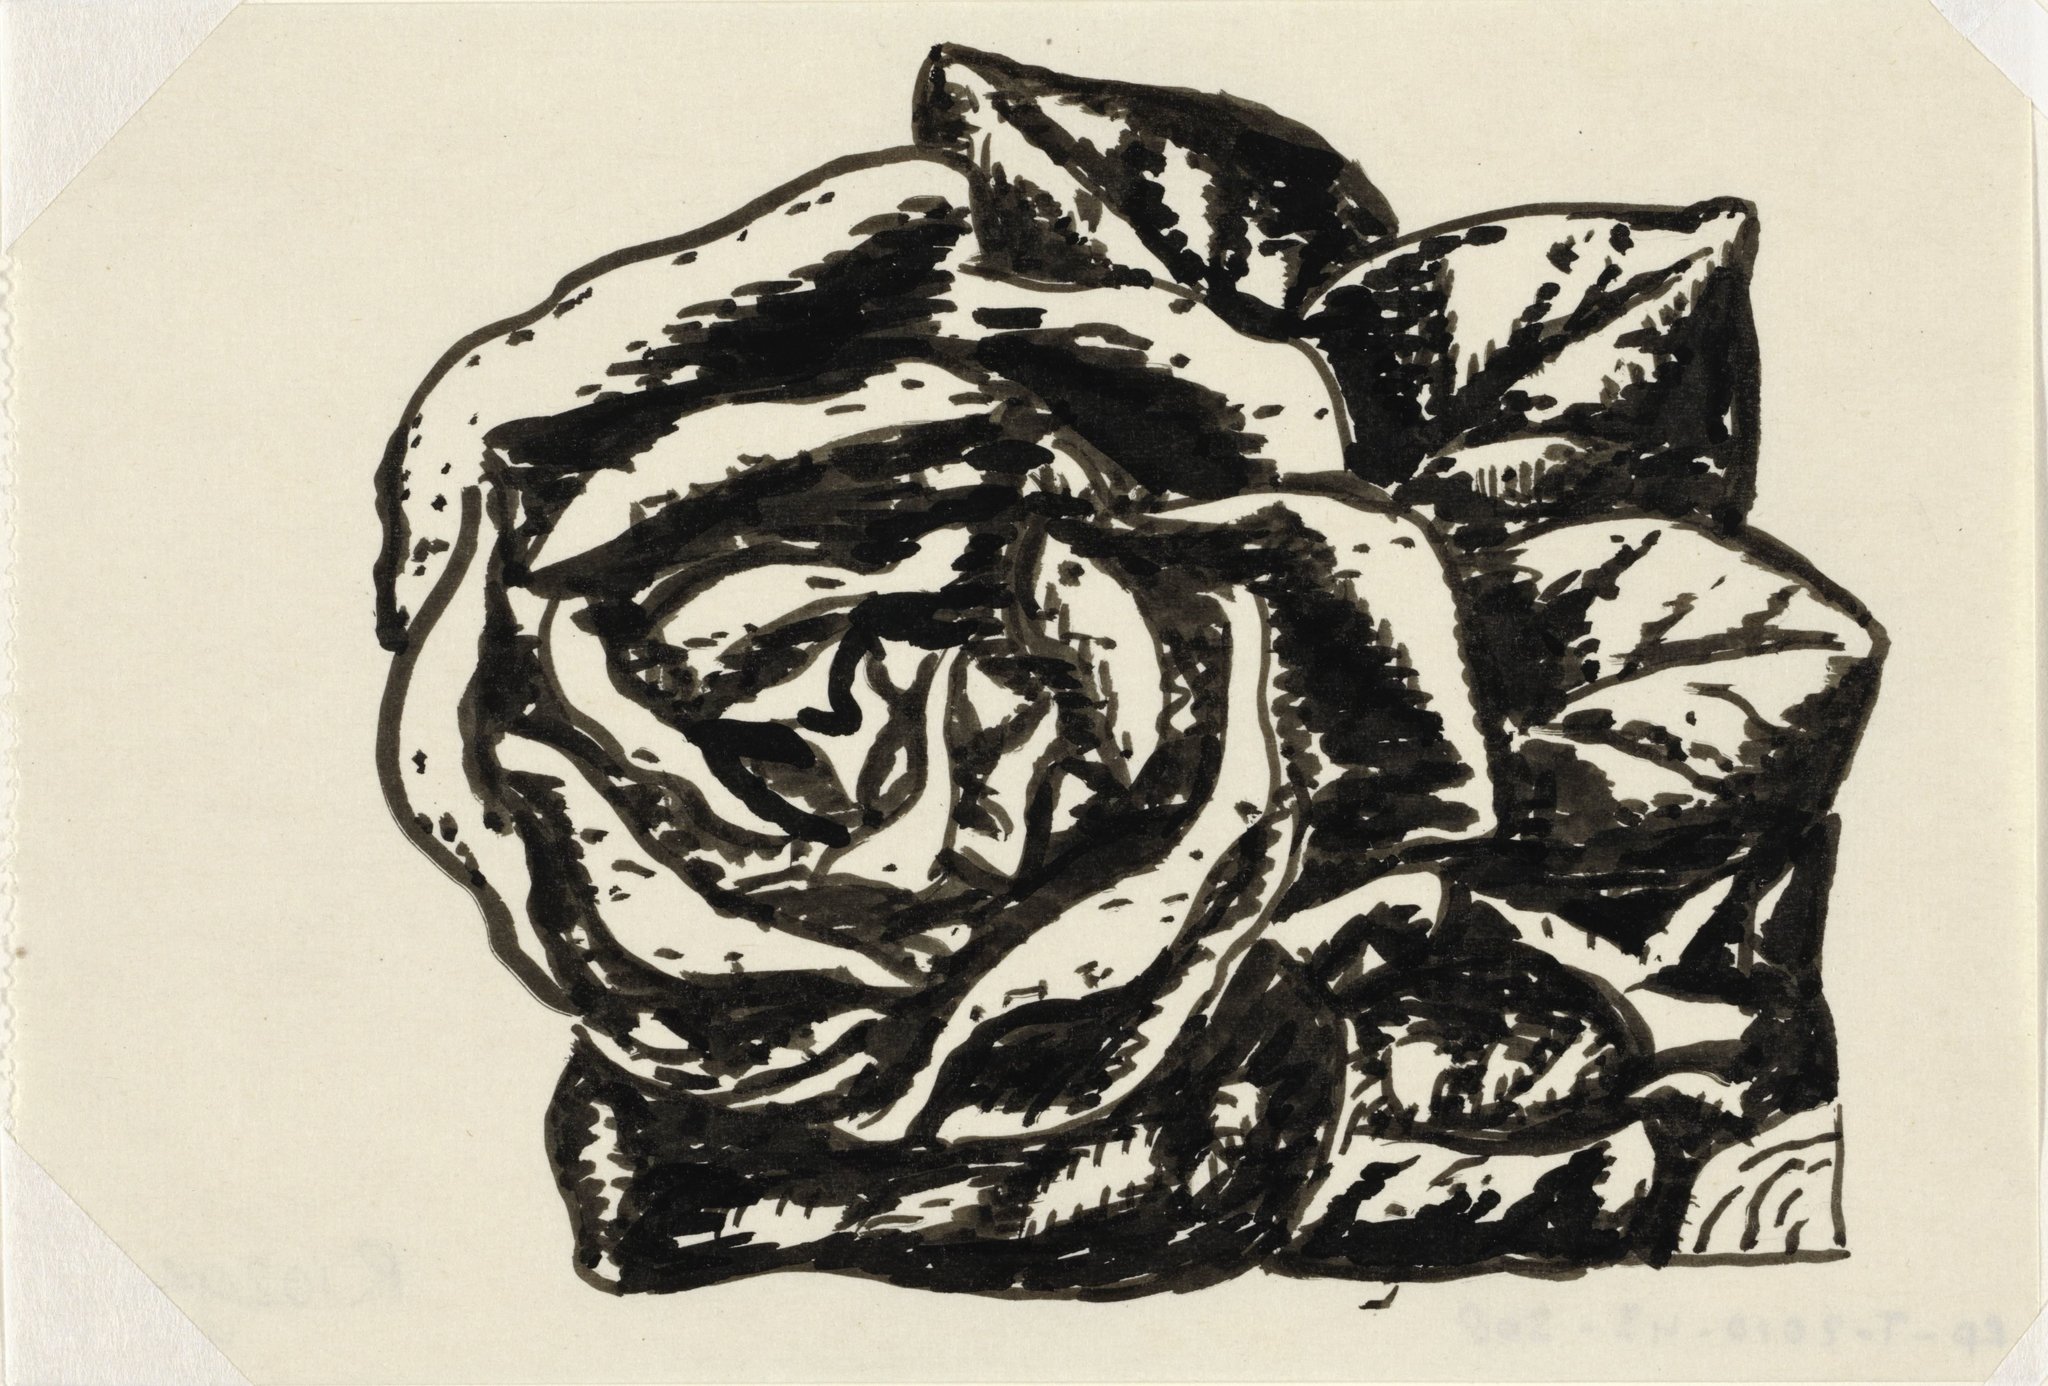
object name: drawing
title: Zonder titel (roos)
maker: leo gestel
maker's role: draughtsman, print maker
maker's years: 1881-1941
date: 1935-1936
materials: ink, paper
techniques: brush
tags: flowers: rose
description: De huidige titels zijn door het museum toegekend bij gebrek aan informatie over een originele titel.